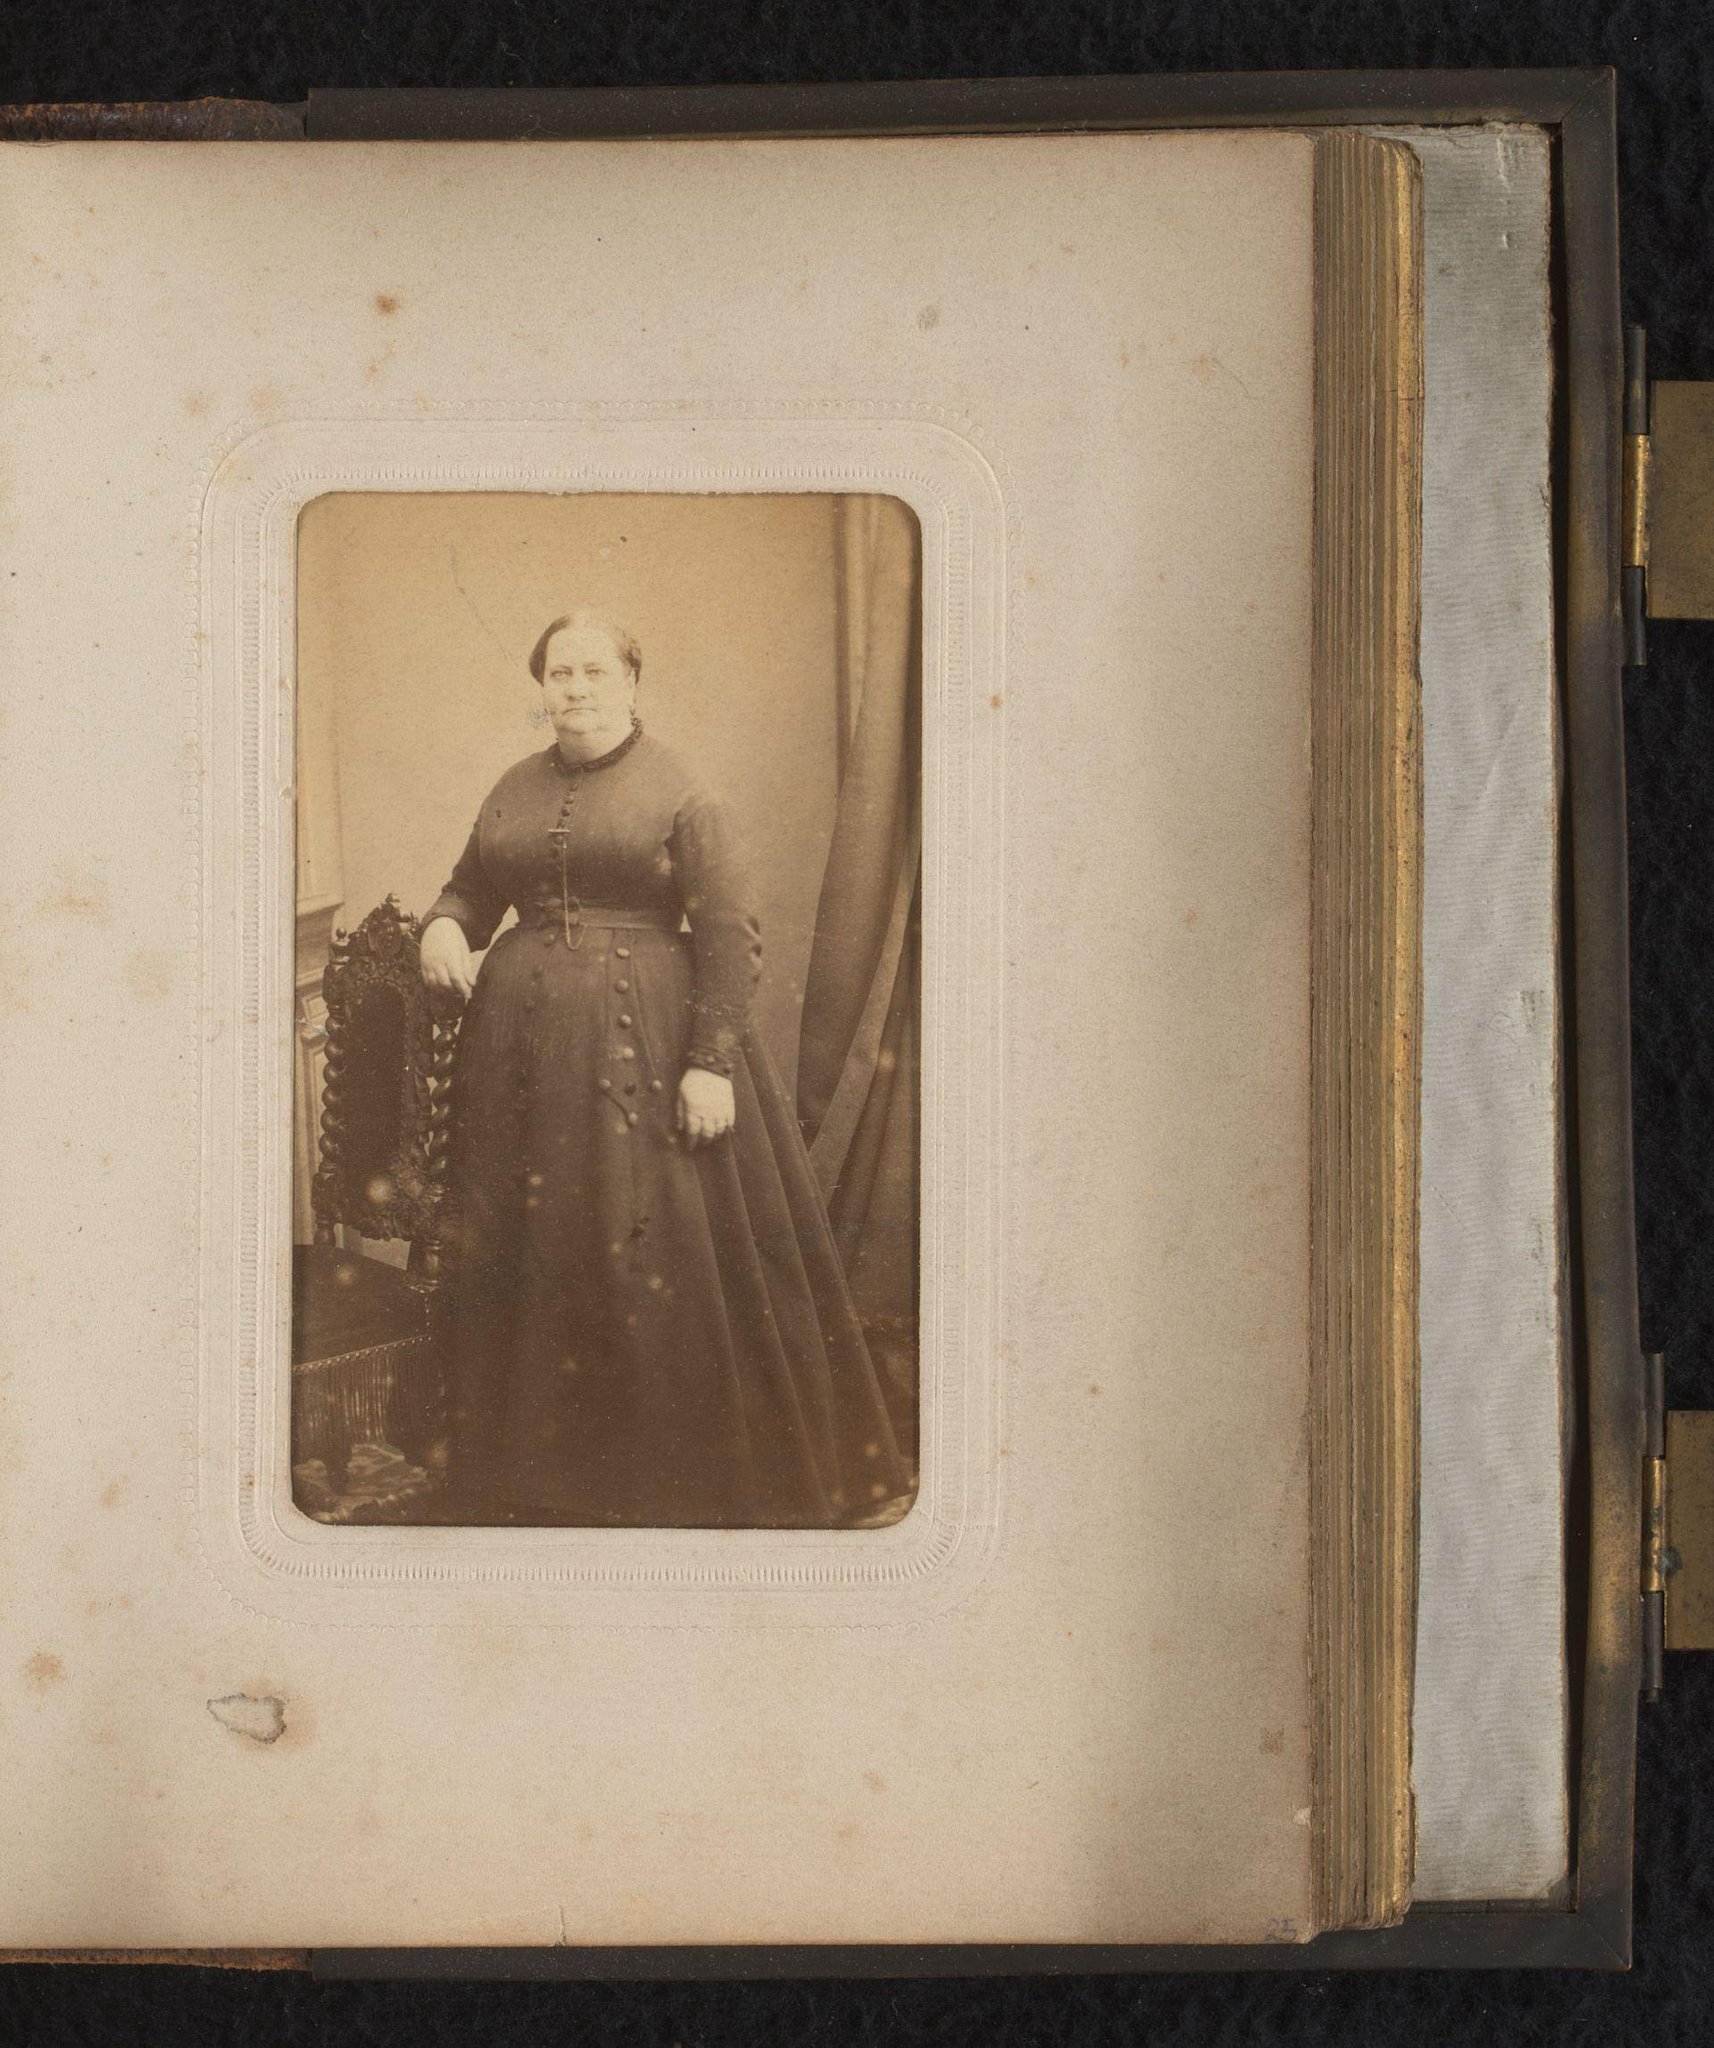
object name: album leaf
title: Portret van een vrouw, staand bij een stoel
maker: théodule antoine courthéoux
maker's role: fotograaf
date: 1860-1900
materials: cardboard, photographic support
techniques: albumen print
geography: paris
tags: historical persons - bb - woman, standing figure - aa - female human figure, chair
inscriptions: inscription: ‘(...)/ PHOTOGRAPHIE/ St VINCENT-DE-PAUL/ 112, Place de Lafayette, 112/ Courthéoux/ PARIS.’